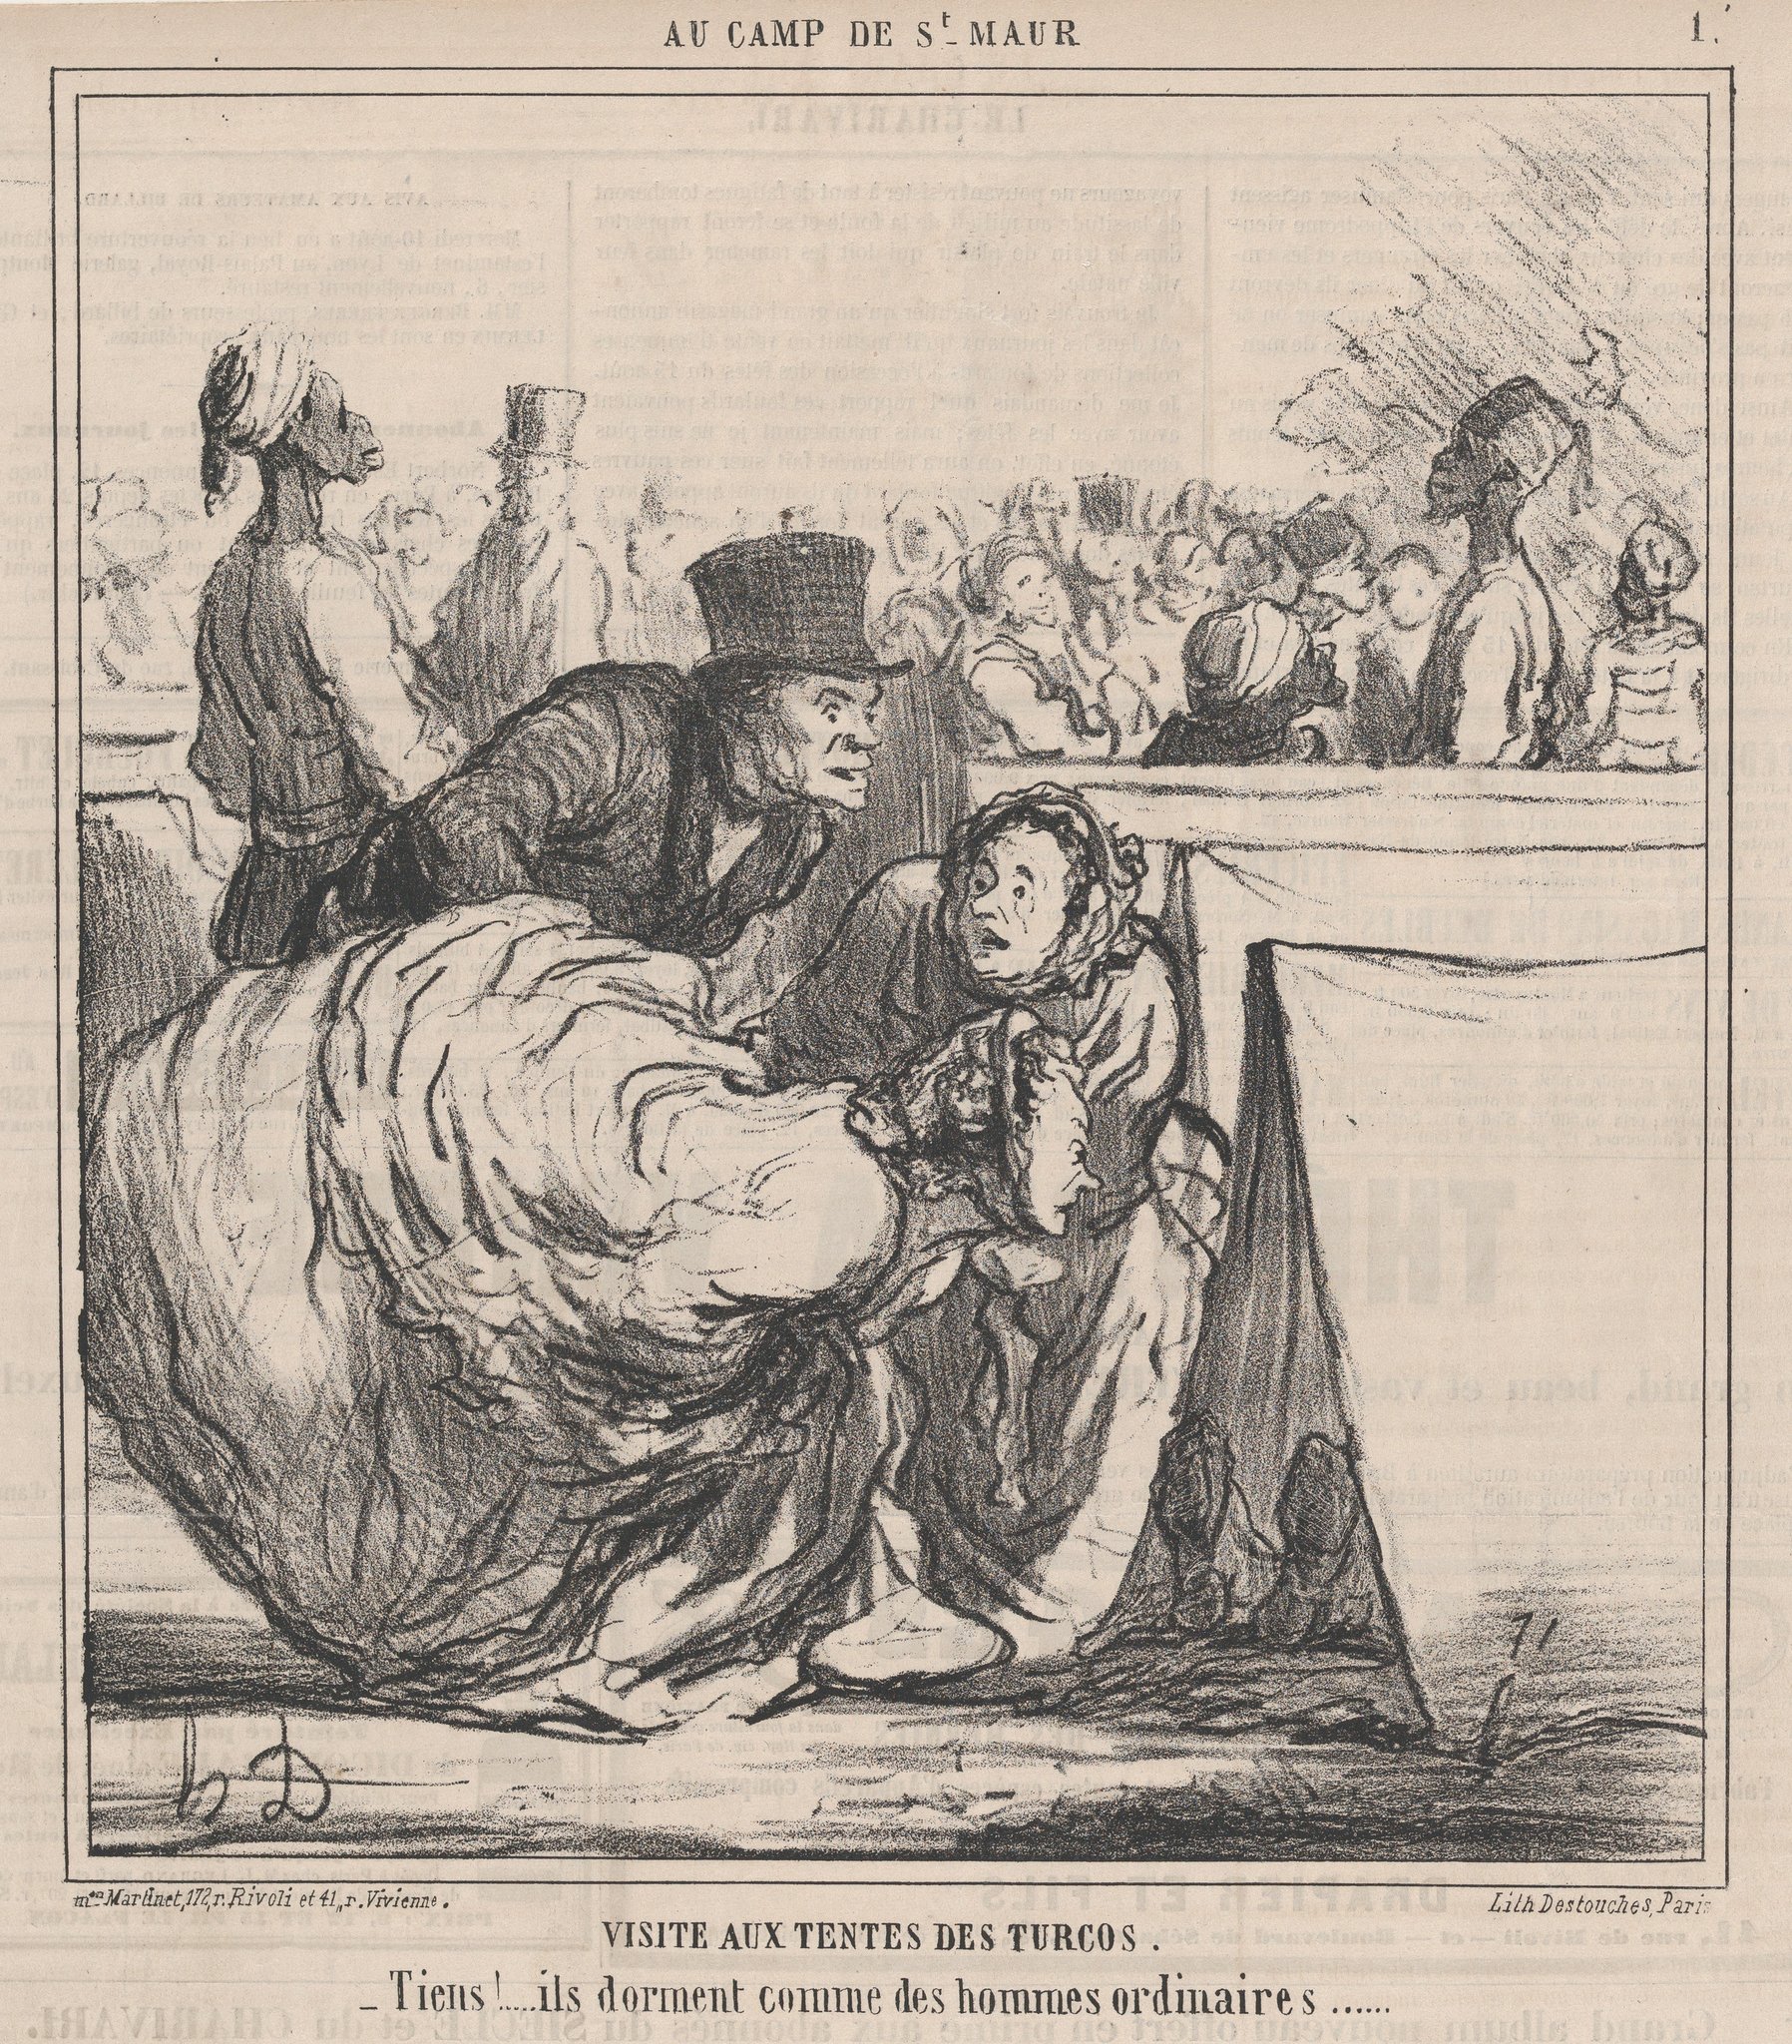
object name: print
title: Visite aux Tentes des Turcos...., from Au Camp de Saint-Maur, published in Le Charivari, August 13, 1859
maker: honoré daumier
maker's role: artist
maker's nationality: french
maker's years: 1808-1879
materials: paper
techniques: lithograph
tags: men,women